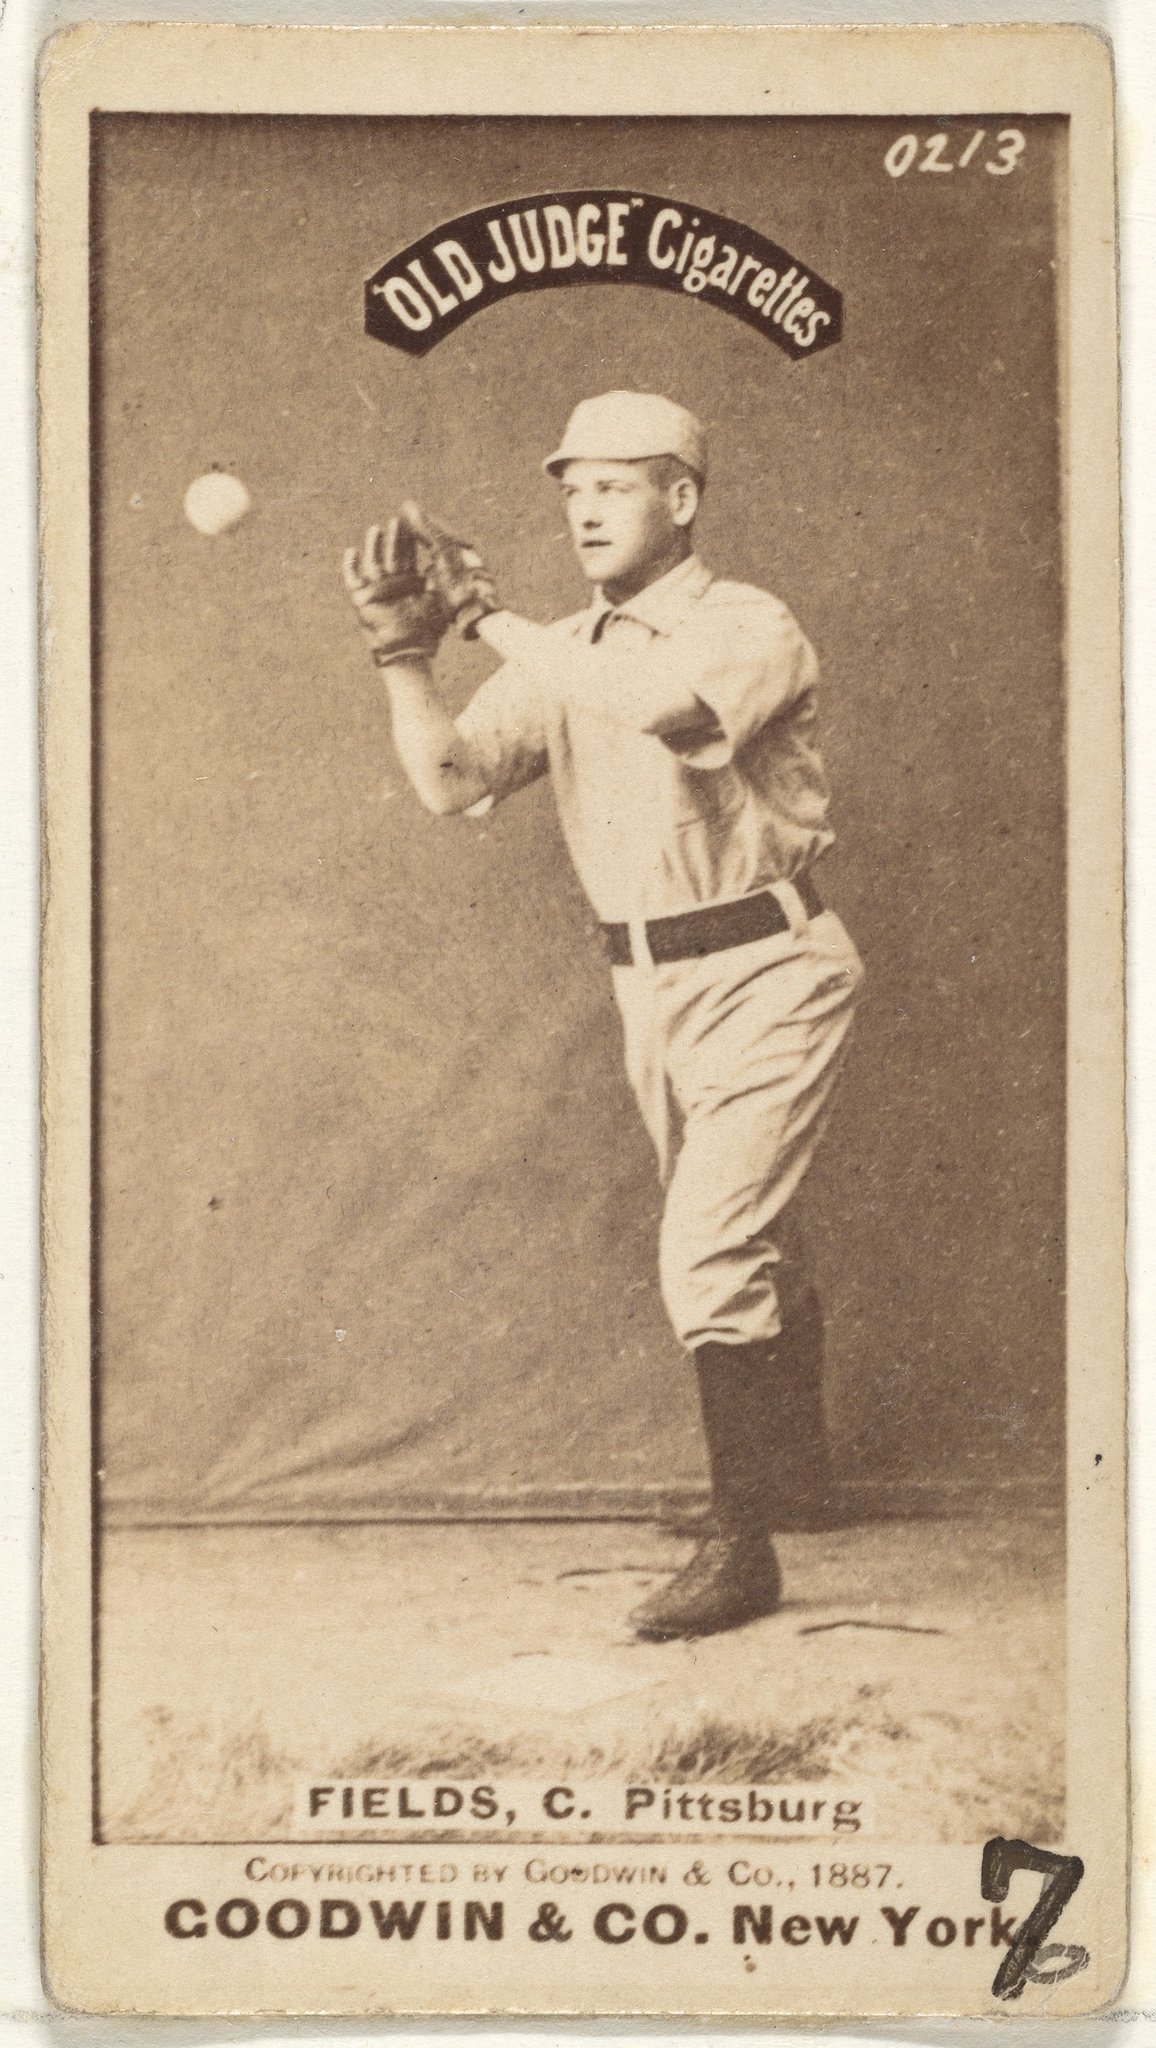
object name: baseball card, photograph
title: John Joseph "Jocko" Fields, Catcher, Pittsburgh, from the Old Judge series (N172) for Old Judge Cigarettes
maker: goodwin & company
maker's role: publisher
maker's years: 1850-1950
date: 1887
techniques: albumen silver print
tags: men,portraits,baseball,athletes